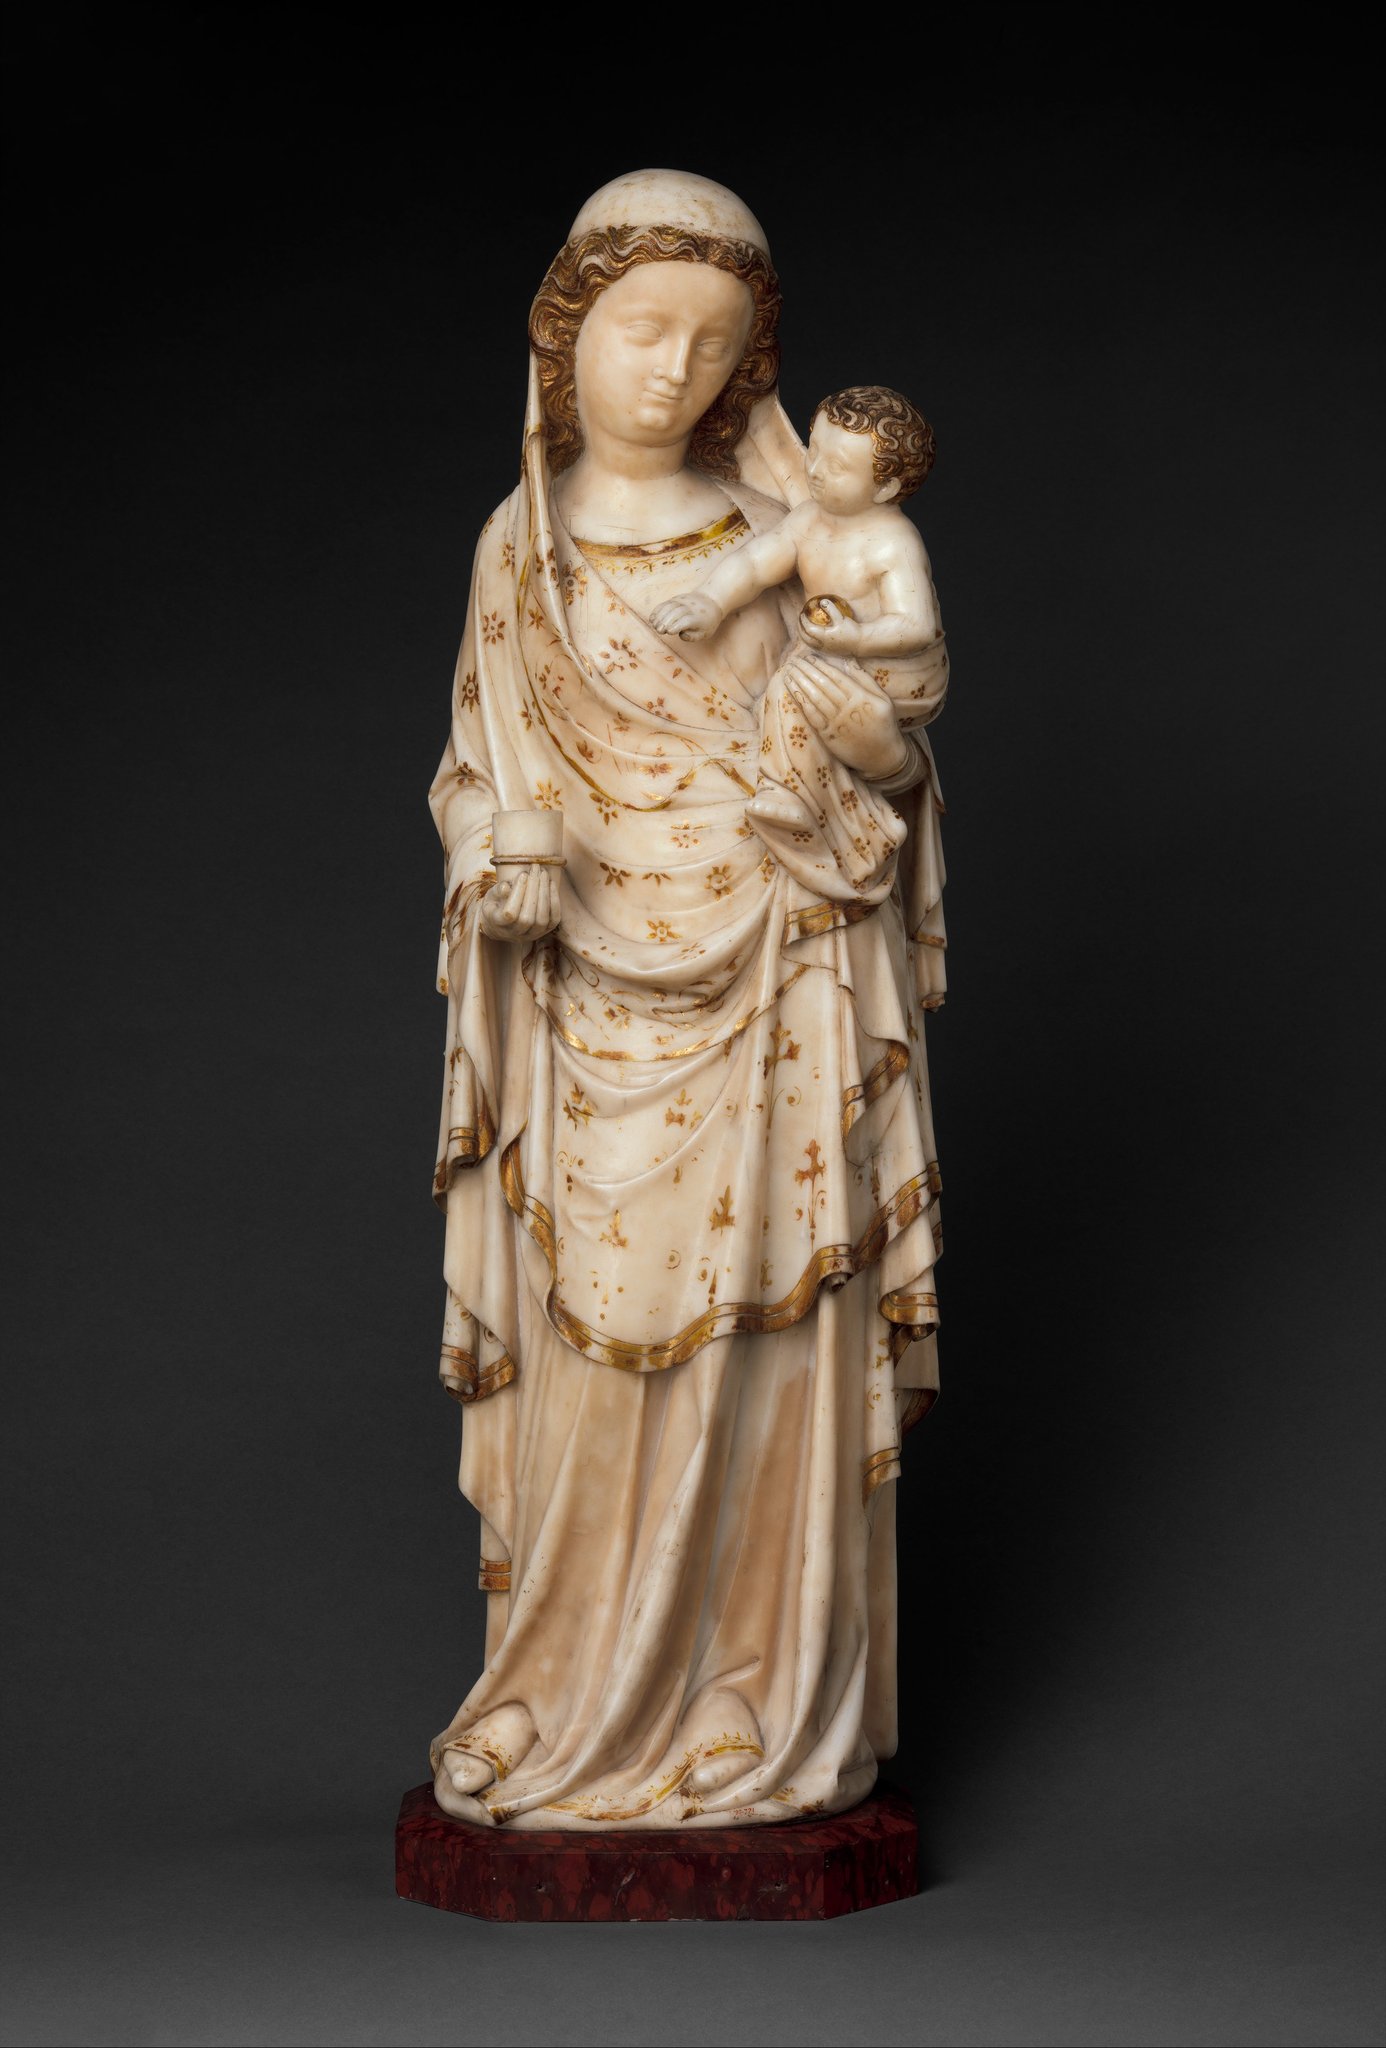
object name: statuette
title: Virgin and Child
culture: french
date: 1340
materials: marble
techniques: gilding